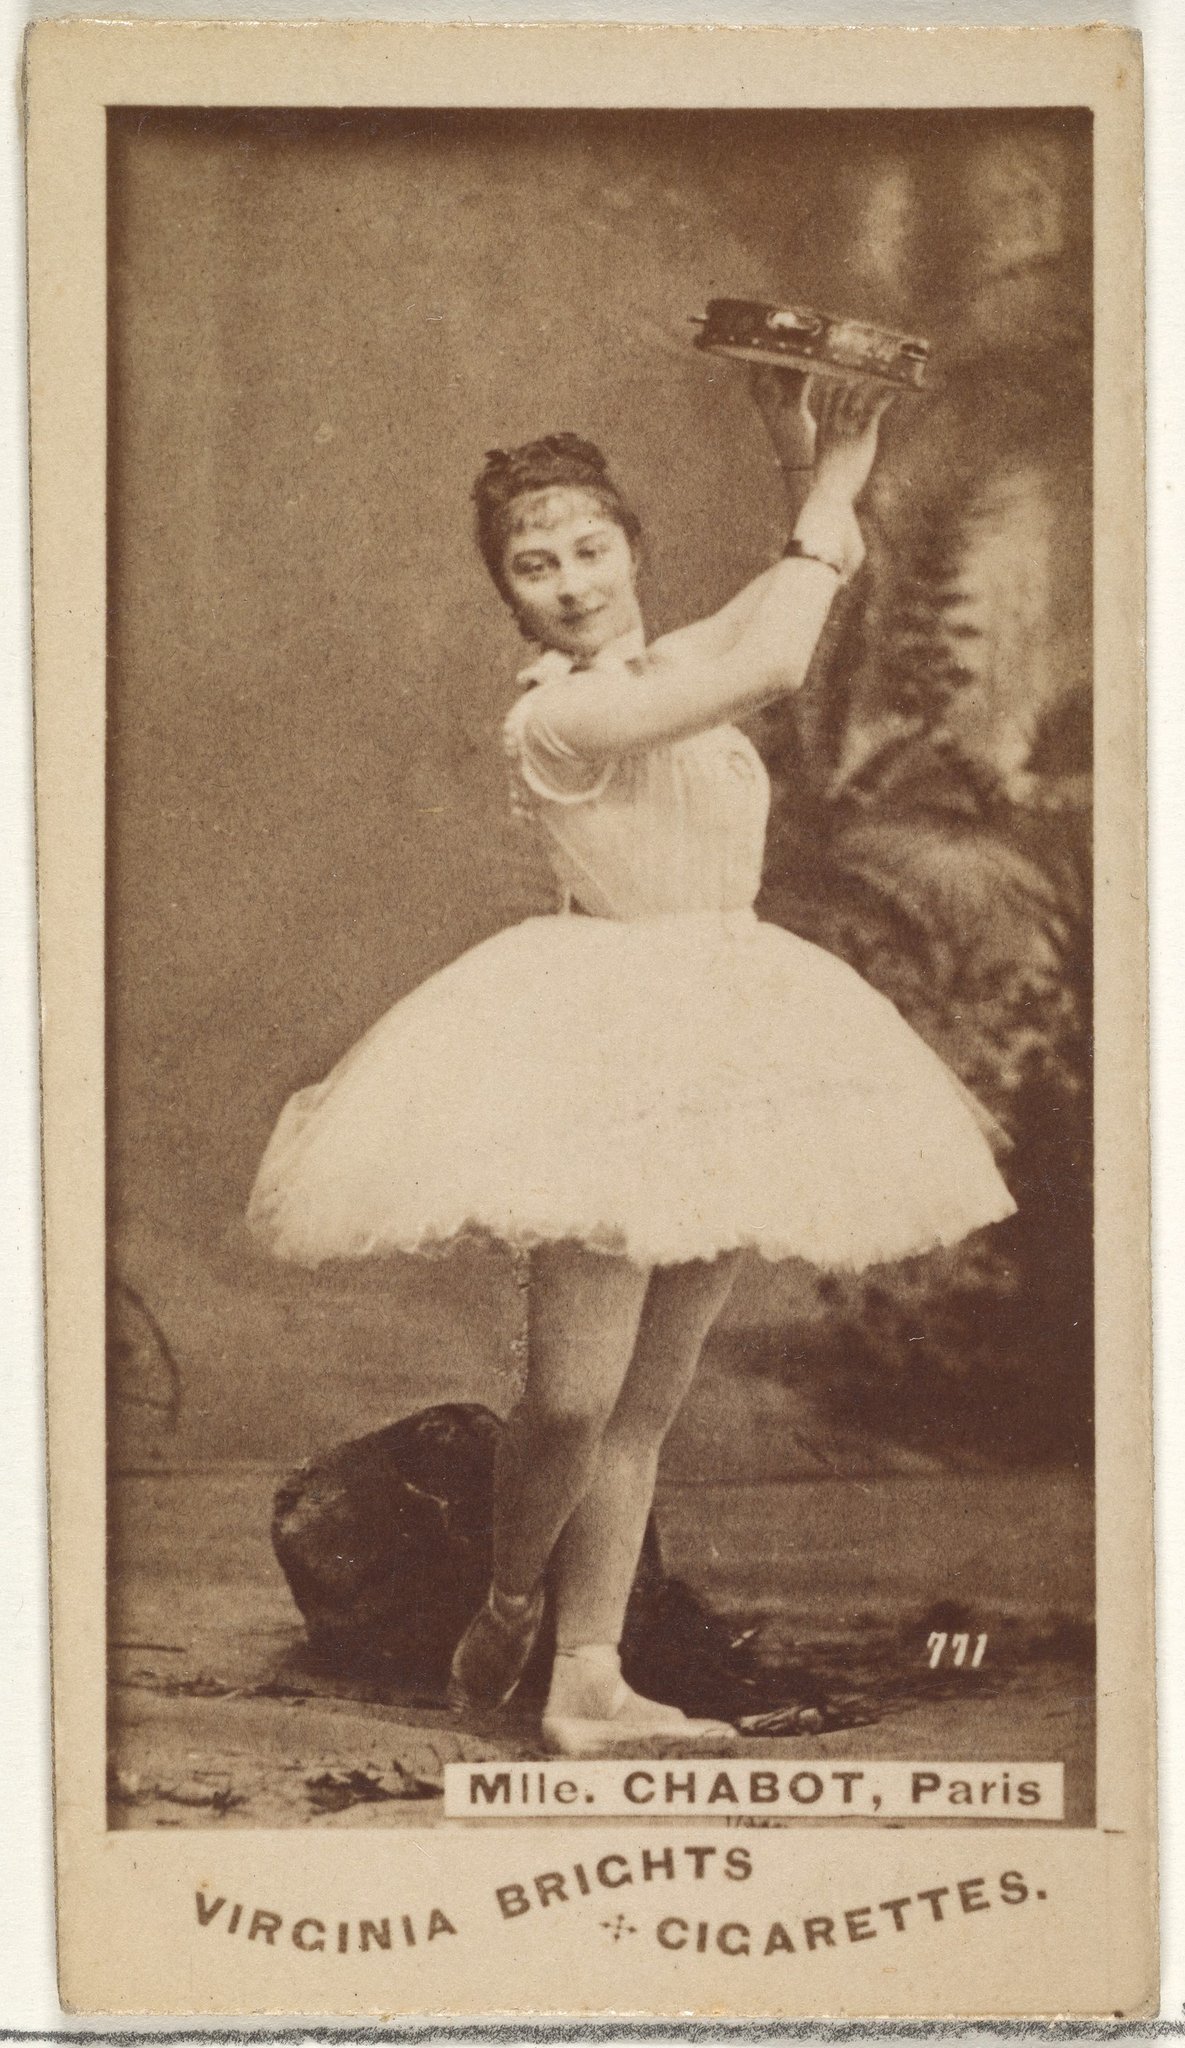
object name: photograph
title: Card 771, Mlle. Chabot, Paris, from the Actors and Actresses series (N45, Type 1) for Virginia Brights Cigarettes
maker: allen & ginter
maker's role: publisher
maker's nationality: american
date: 1888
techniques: albumen silver print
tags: portraits,women,dancers,ballet